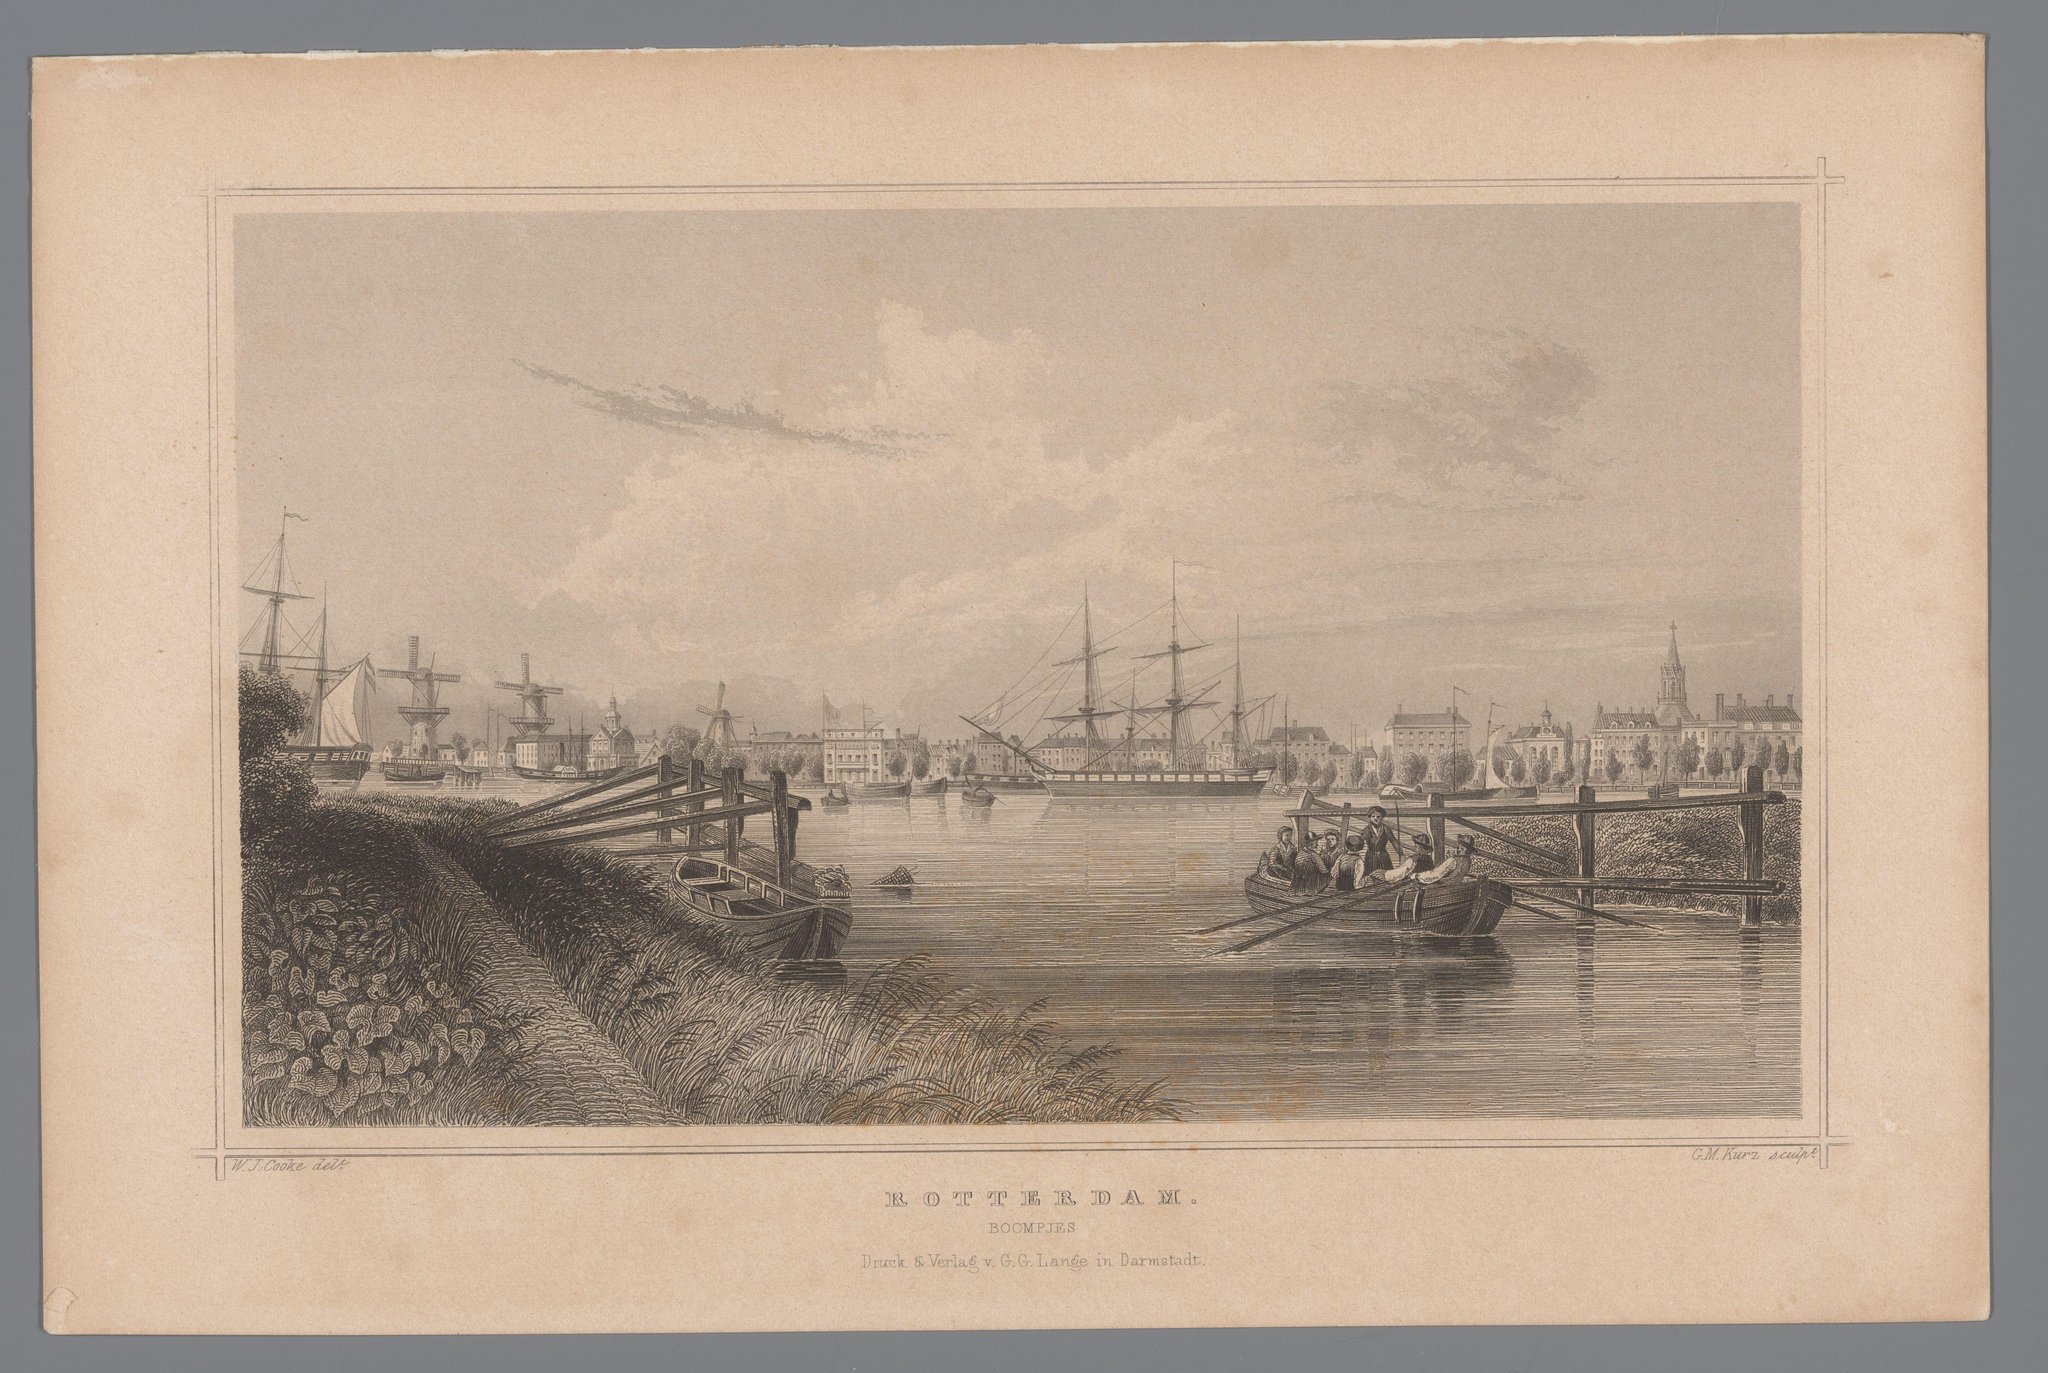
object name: book illustration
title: Rotterdam. Boompjes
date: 1863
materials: paper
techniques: engraving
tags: sailing-ship, sailing-boat, city-view in general; 'veduta', rowing-boat, canoe, etc., windmill, rotterdam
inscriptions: collector's mark: Lugt 2233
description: Prent uit: Der Rhein und die Rheinlande in malerischen Original-ansichten. 3 dln. Darmstadt: G.G. Lange, 1863, dl. 3, p. 128-129. Dezelfde prent, met een ander onderschrift, komt ook voor in: Terwen, J.L. Het koningrijk der Nederlanden (...). 2 dln. Gouda: G.B. van Goor, 1857, p. 252-253.